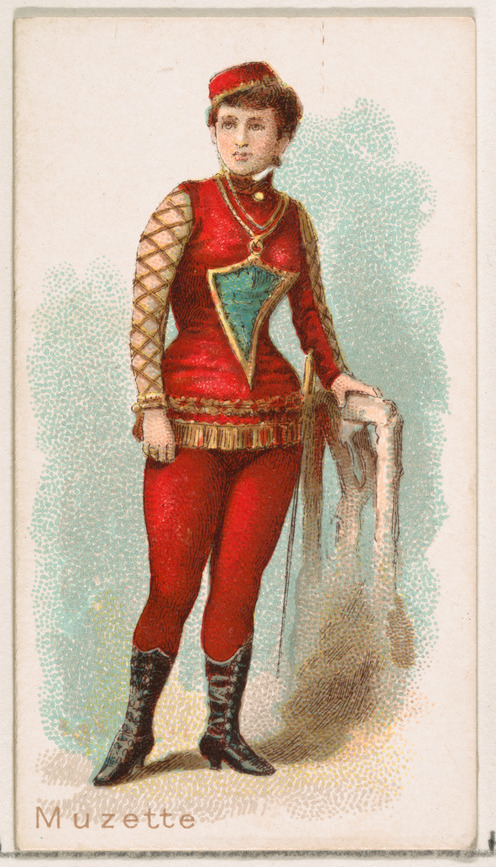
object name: print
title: Muzette, from the Ballet Queens series (N182) issued by Wm. S. Kimball & Co.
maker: william s. kimball & company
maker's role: publisher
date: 1889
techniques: color lithograph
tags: women,dancers